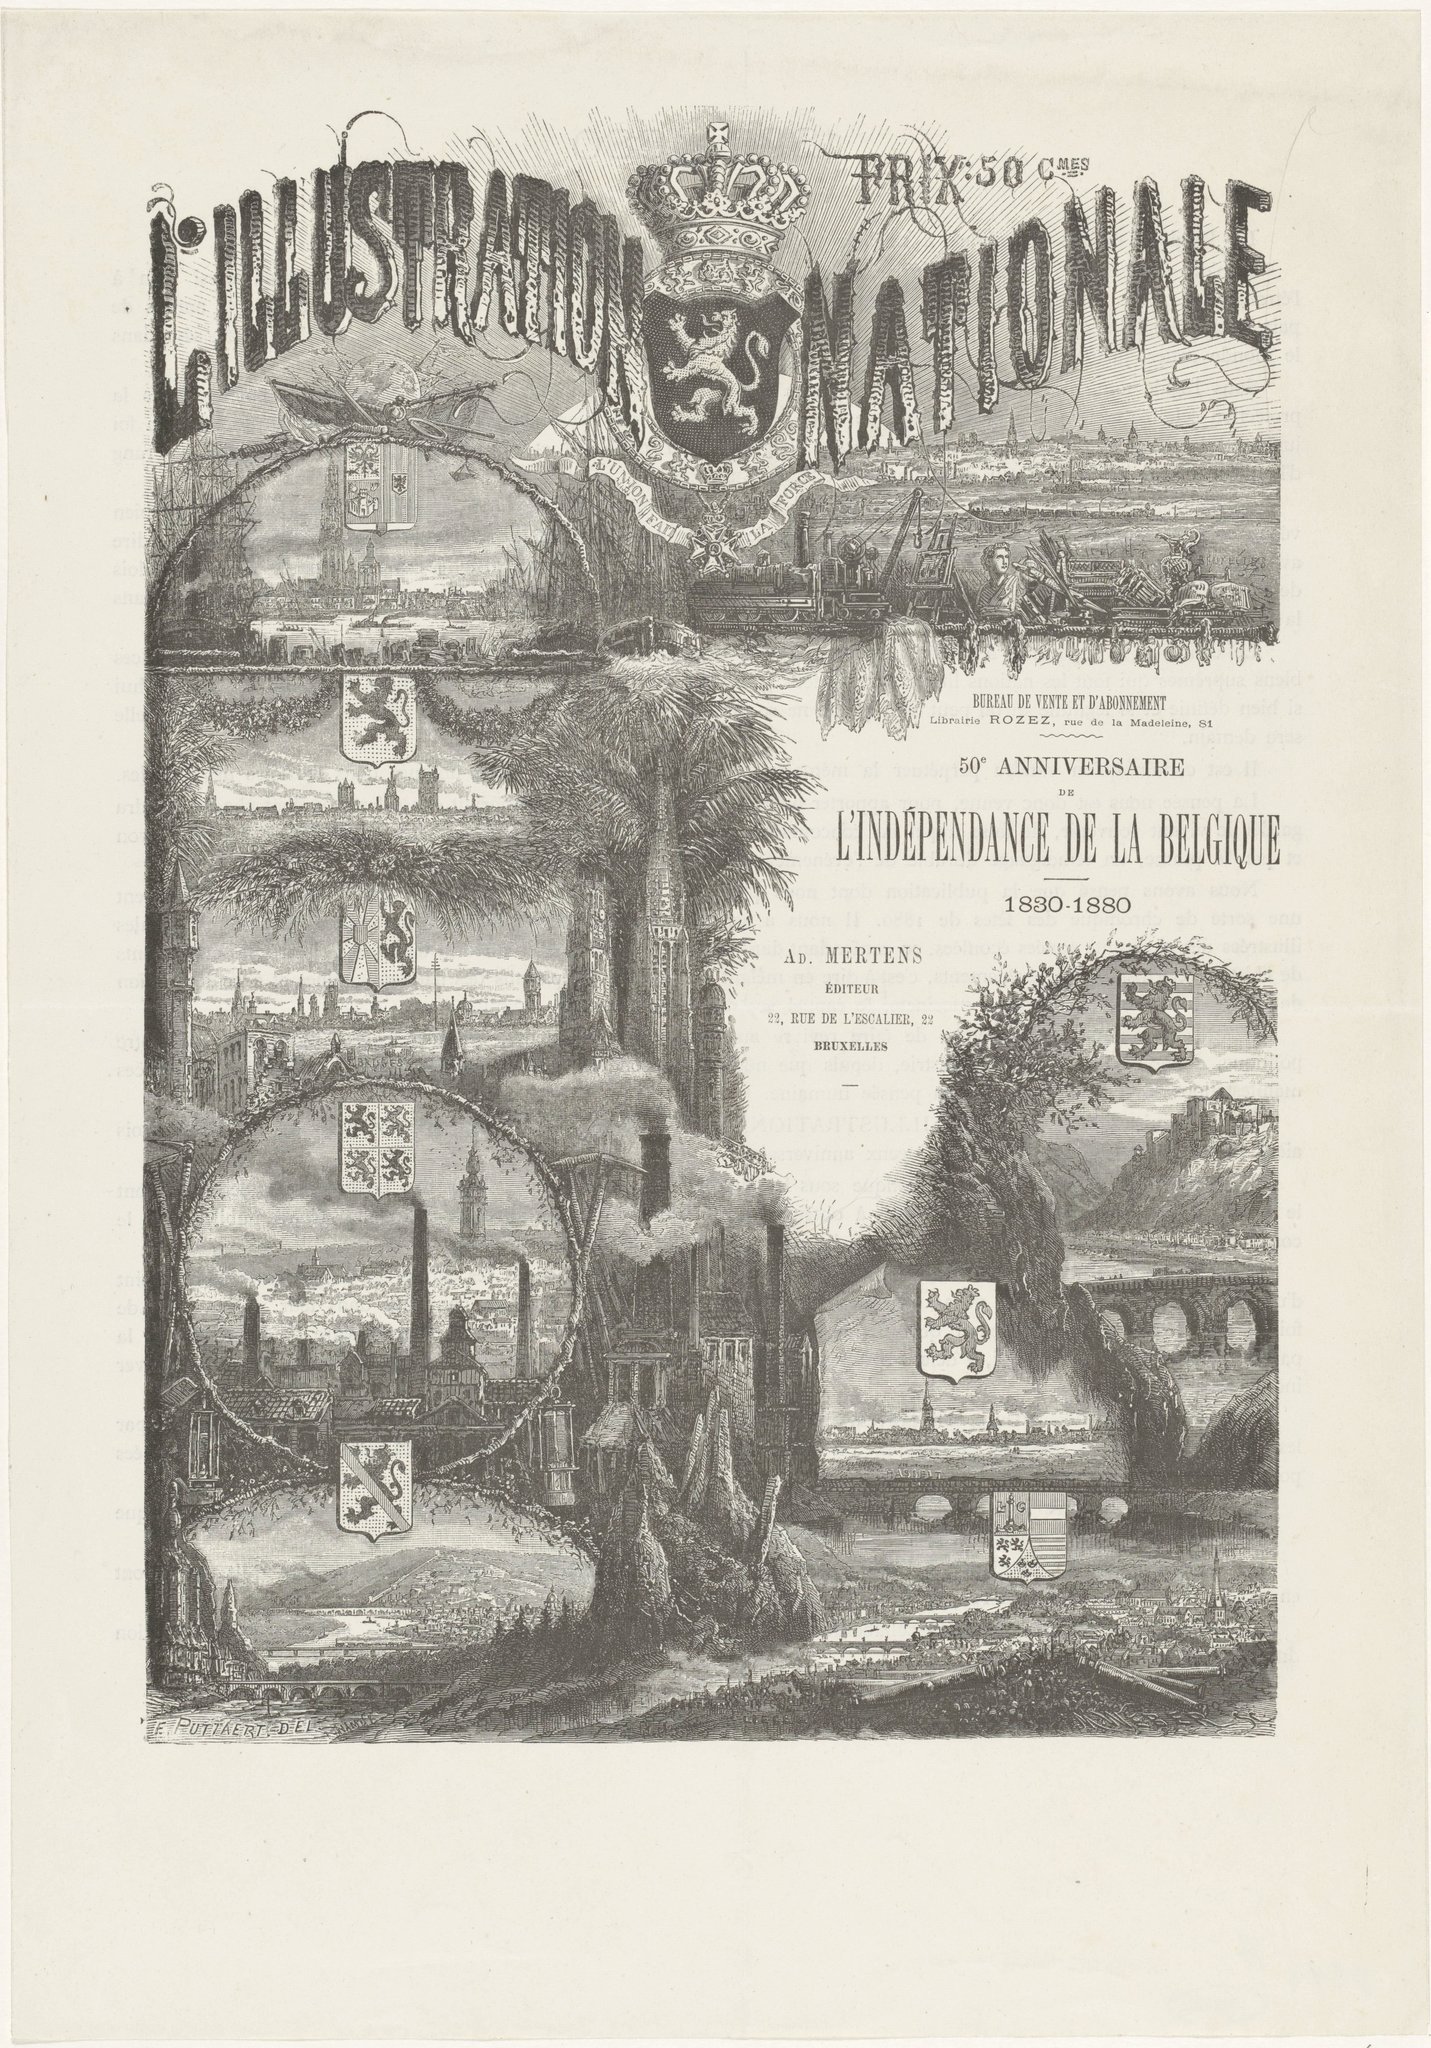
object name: print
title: L'Illustration Nationale / 50e Anniversaire L'Indépendance de la Belgique / 1830-1880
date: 1880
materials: paper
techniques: engraving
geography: brussels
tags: belgische revolutie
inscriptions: collector's mark: Lugt 2228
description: Titelblad van het tijdschrift 'L'Illustration Nationale', editie van augustus 1880 ter gelegenheid van het vijftigjarig jubileum van de Belgische onafhankelijkheid, 1830-1880. Negen gezichten op de belangrijkste Belgische steden, afgebeeld tussen bomen en torens. Bovenaan het Belgische wapen. Met tekst op verso.